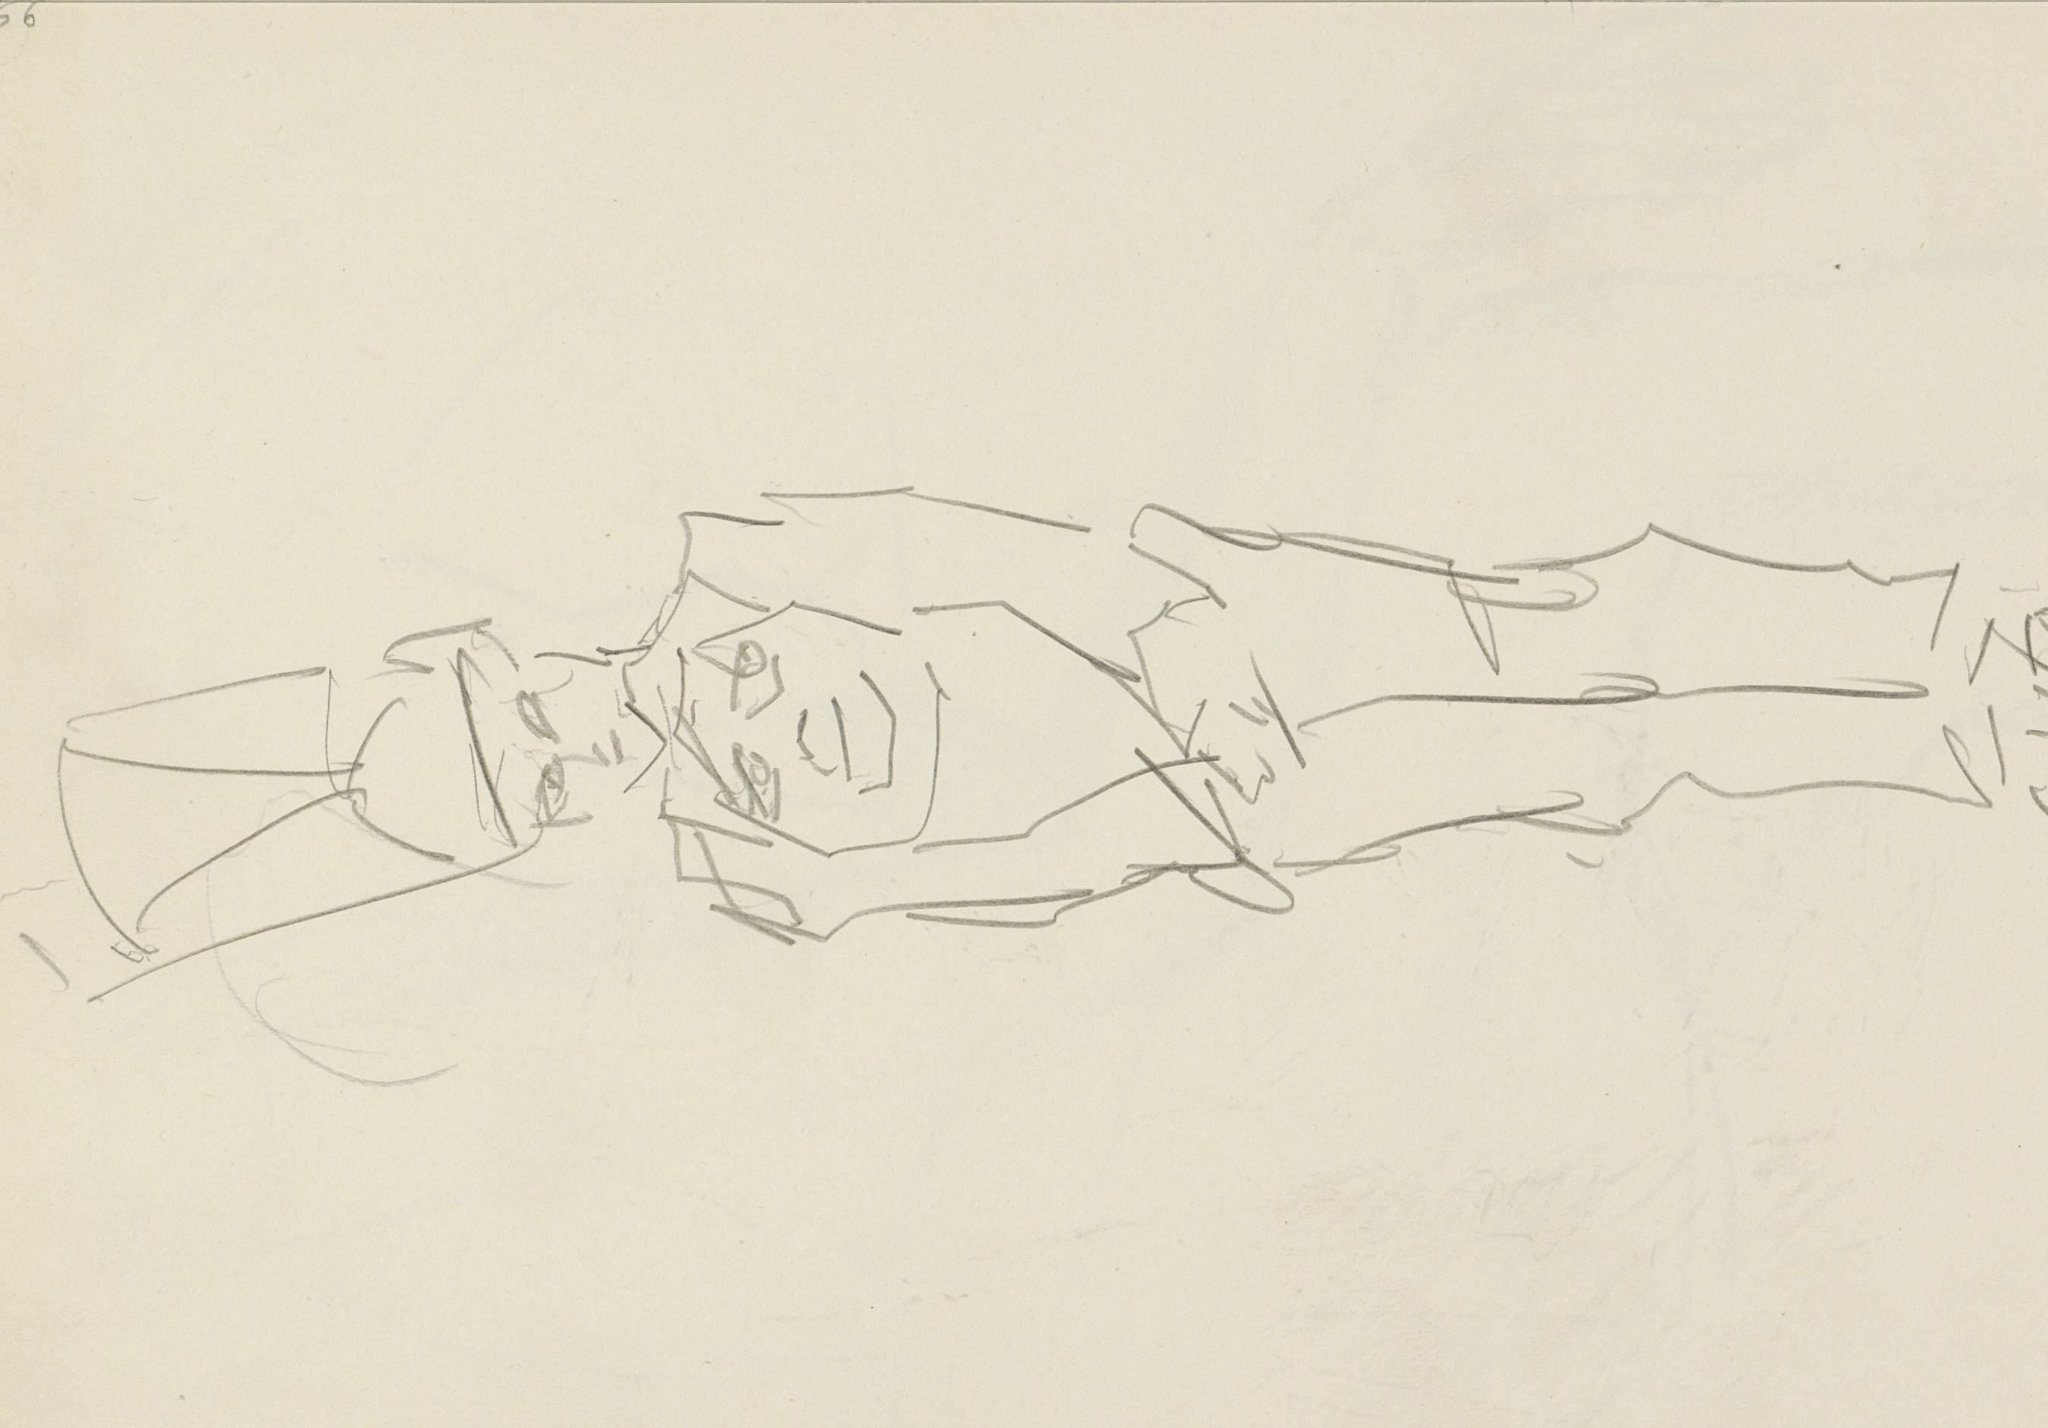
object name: sketchbook leaf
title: Staande figuur in kostuum, mogelijk een variétéartiest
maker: isaac israels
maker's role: draughtsman, painter, print maker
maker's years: 1865-1934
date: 1915-1934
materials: paper, pencil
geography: the hague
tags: standing figure, stage costume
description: Blad 19 verso uit schetsboek XXV met 23 bladen.